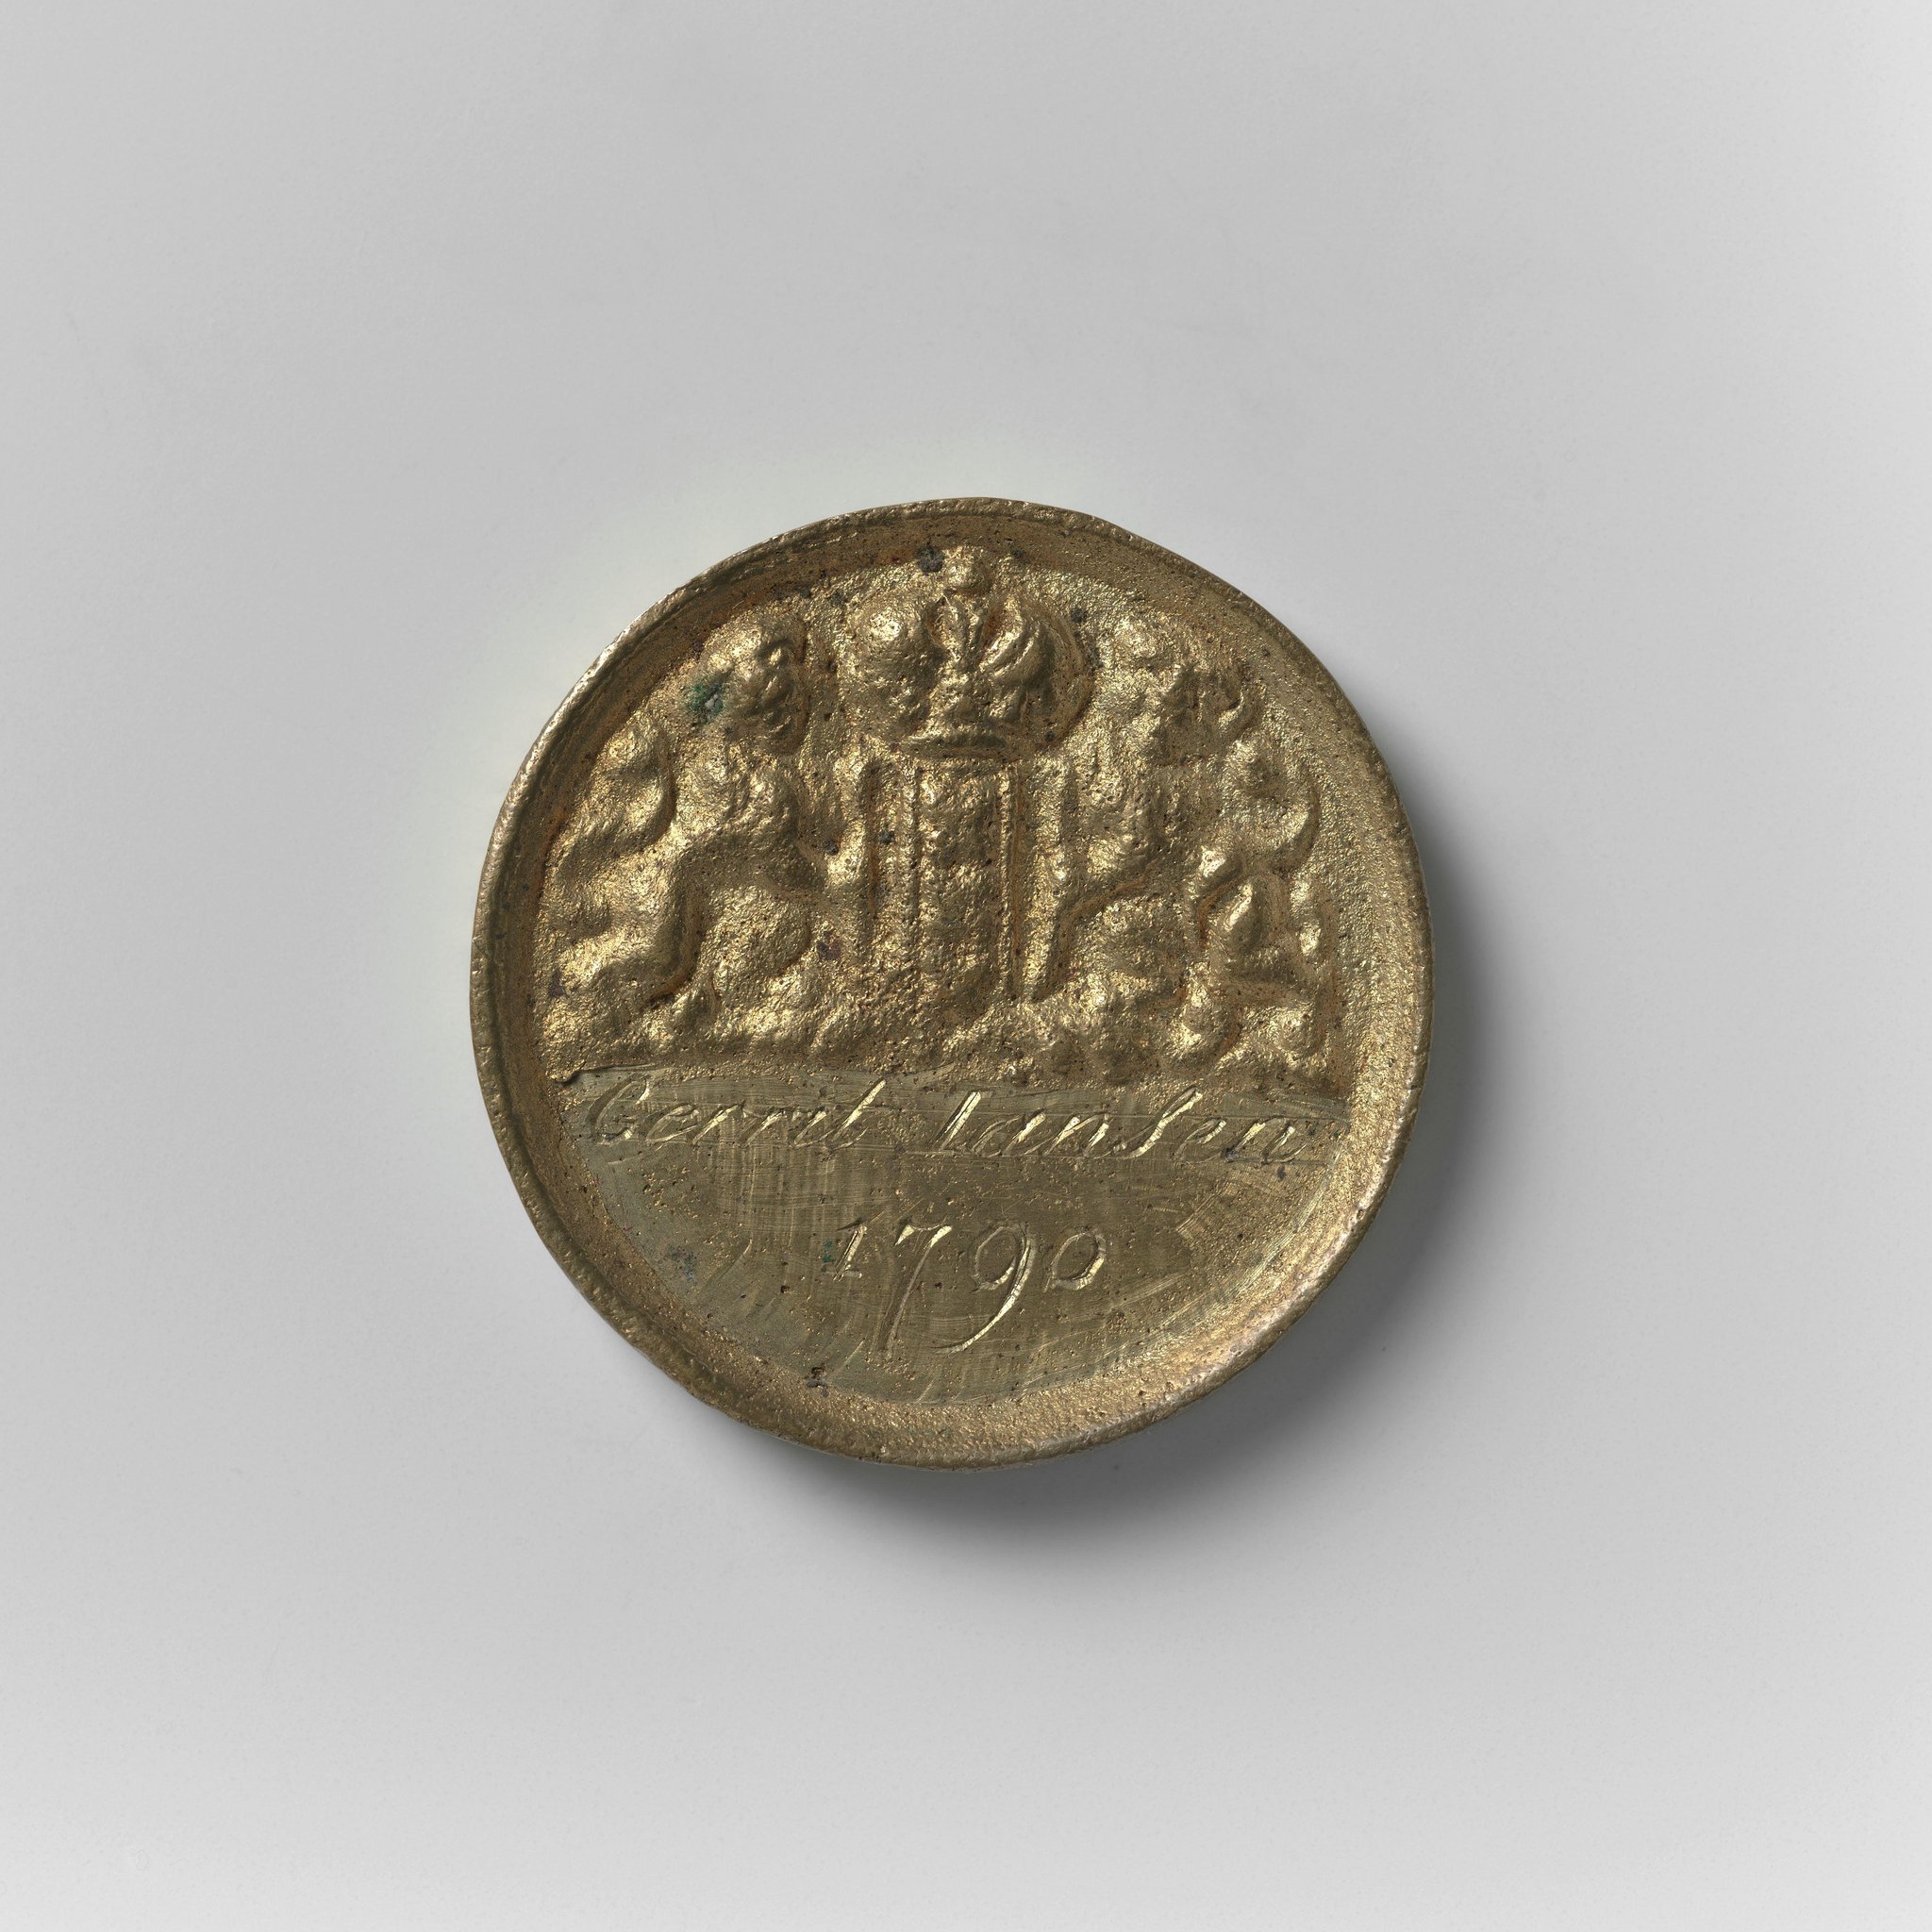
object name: history medal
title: Presentiepenning van het Sint Josephs- of Timmermansgilde te Amsterdam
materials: brass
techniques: casting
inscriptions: inscription: ‘Gerrit Iansen / 1790’, circumscription: ‘.DE.VLUGHT.VAN.EGIPTEN.’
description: Gegoten messing penning met op de voorzijde Jozef met stok en Maria met Jezus op ezel naar links, met omschrift, op de keerzijde een gekroond wapenschild Amsterdam met dragers boven een inscriptieruimte, op naam van Gerrit Jansen 1790